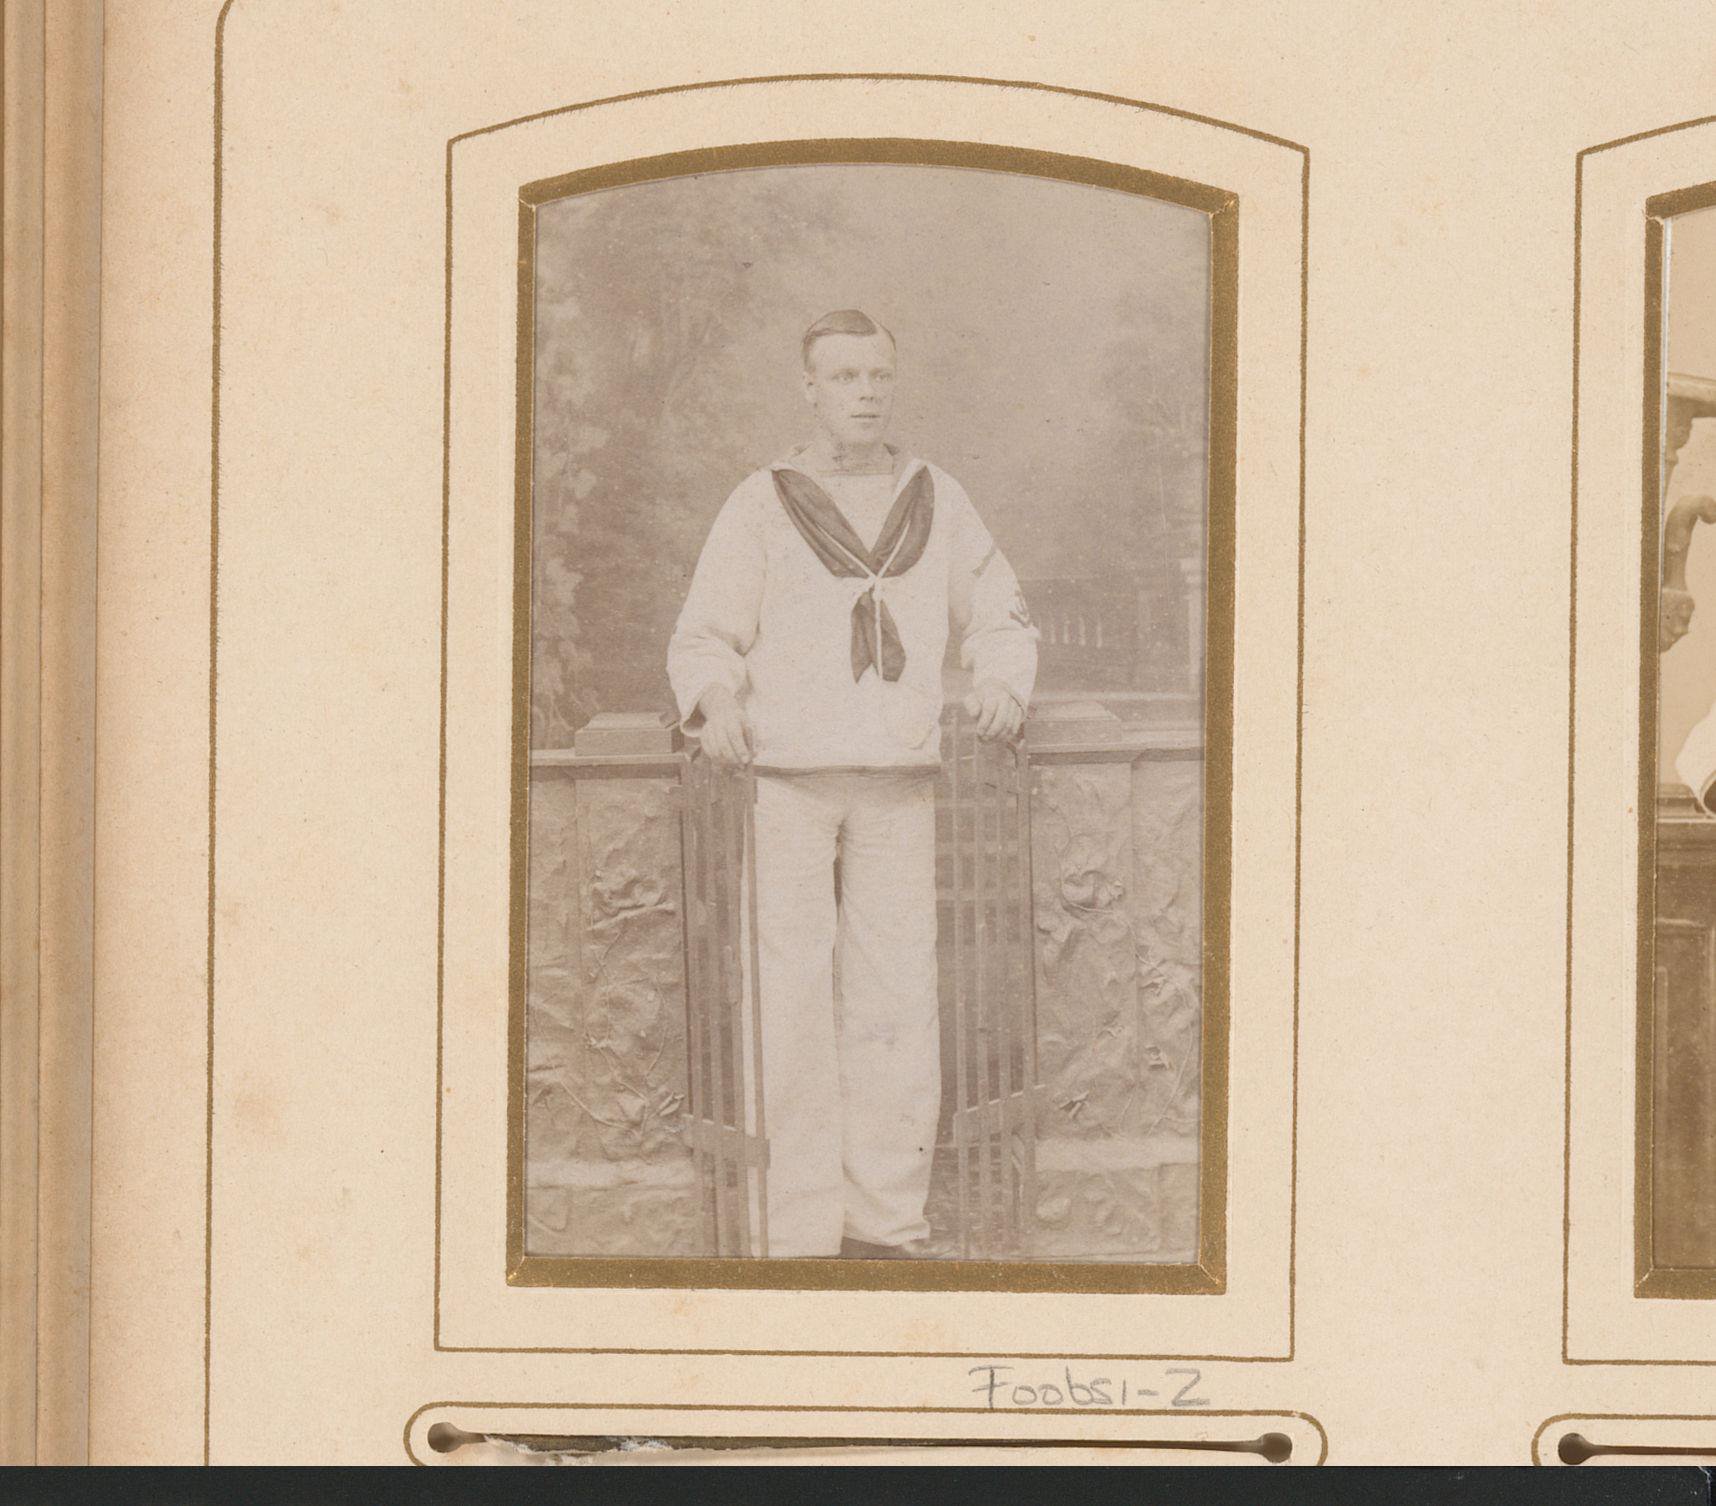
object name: album leaf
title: Portret van een matroos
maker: h.j. davison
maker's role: fotograaf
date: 1880-1915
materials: cardboard, photographic support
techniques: albumen print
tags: adult man, historical persons, seaman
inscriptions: inscription: ‘Strada Reale 57, Valletta, Malta’